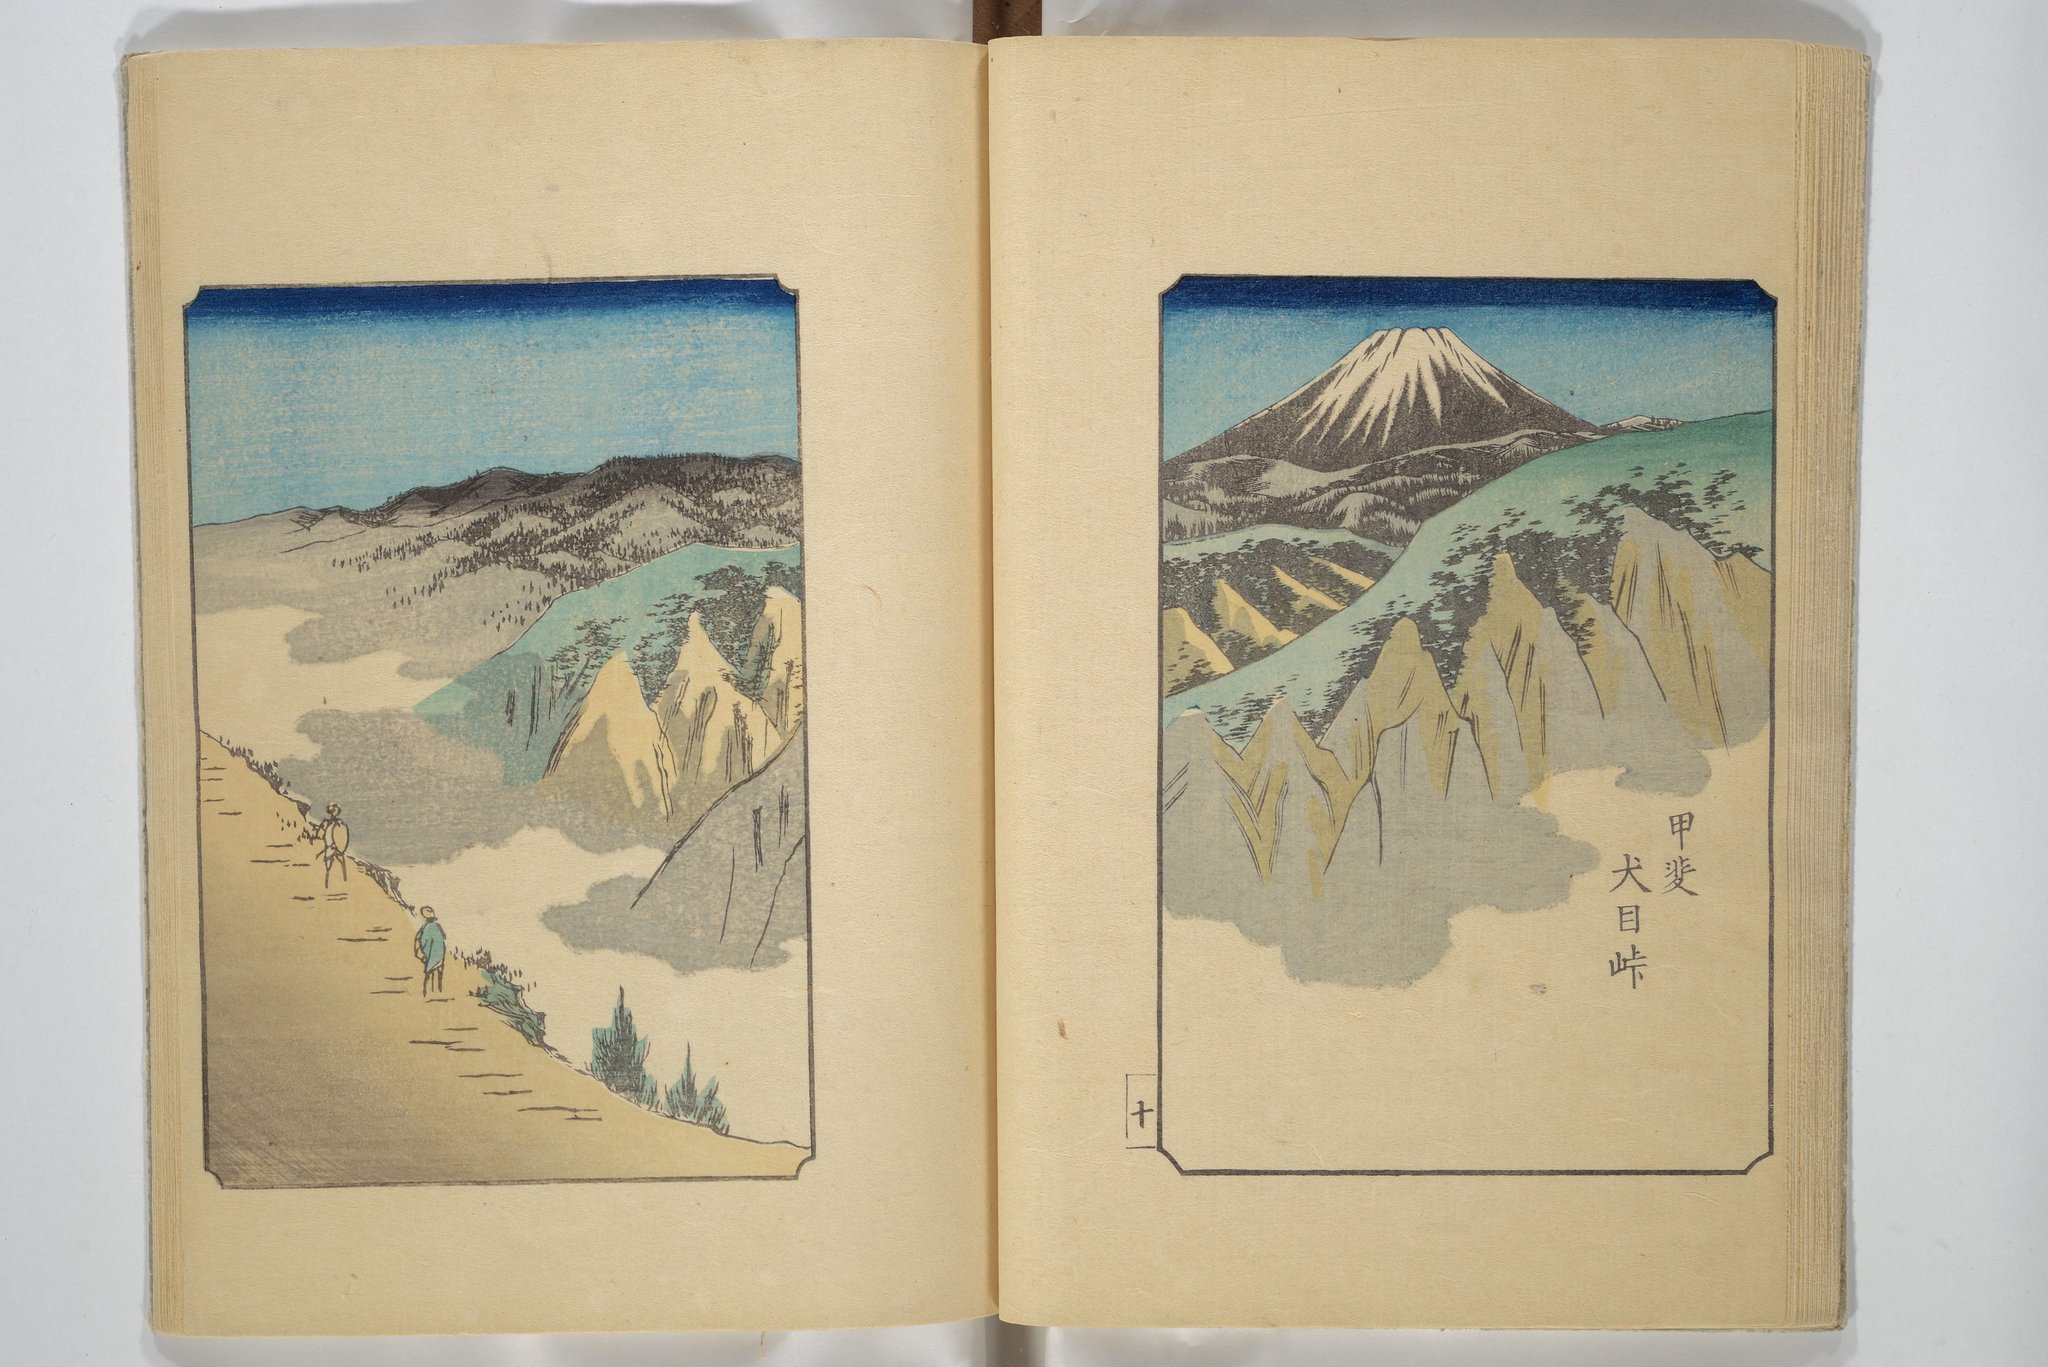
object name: illustrated book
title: One Hundred Views of Mount Fuji (Fujimi hyakuzu) 富士見百図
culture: japanese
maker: utagawa hiroshige 歌川広重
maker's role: artist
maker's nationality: japanese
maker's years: 1797-1858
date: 1859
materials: ink, paper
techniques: woodblock print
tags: human figures,mountains